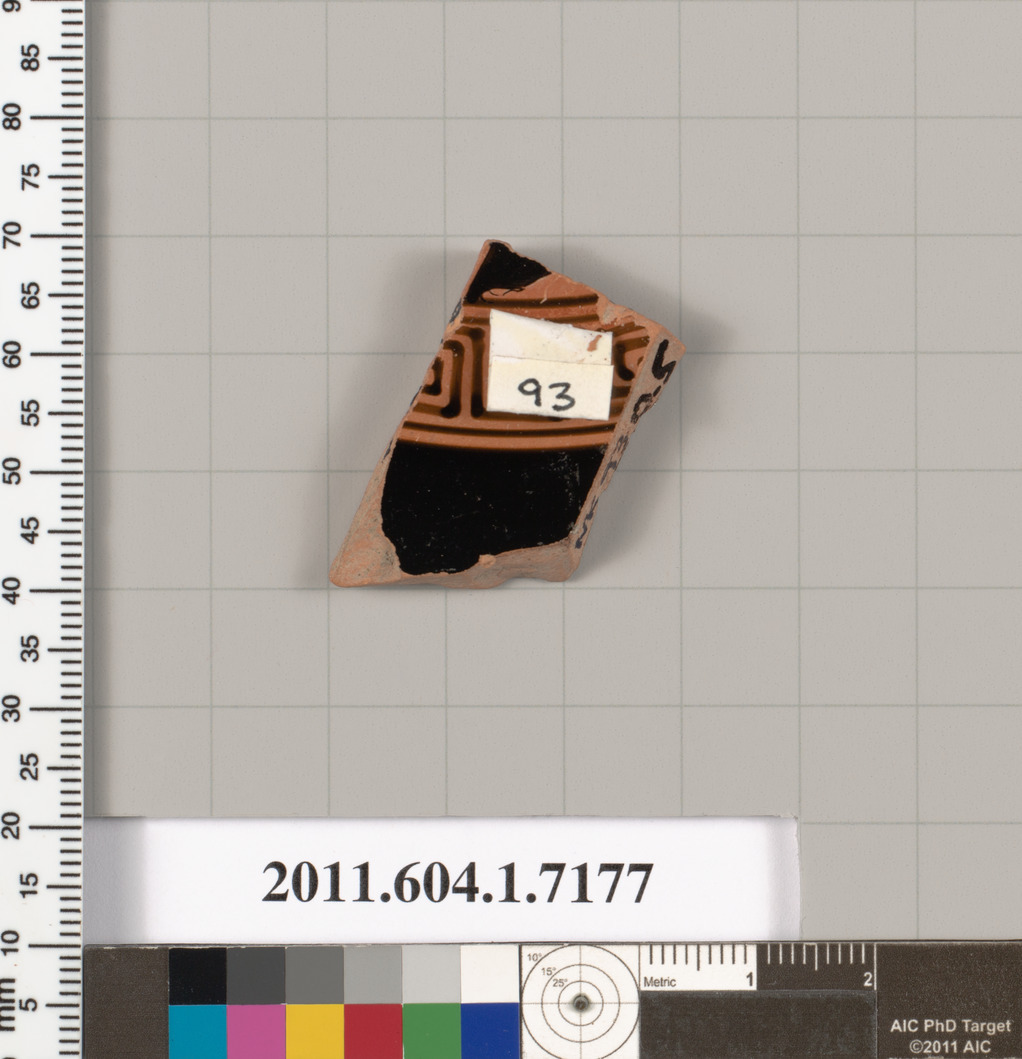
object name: kylix fragment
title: Terracotta fragment of a kylix (drinking cup)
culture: greek, attic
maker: makron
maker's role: artist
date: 500-480 BCE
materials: terracotta